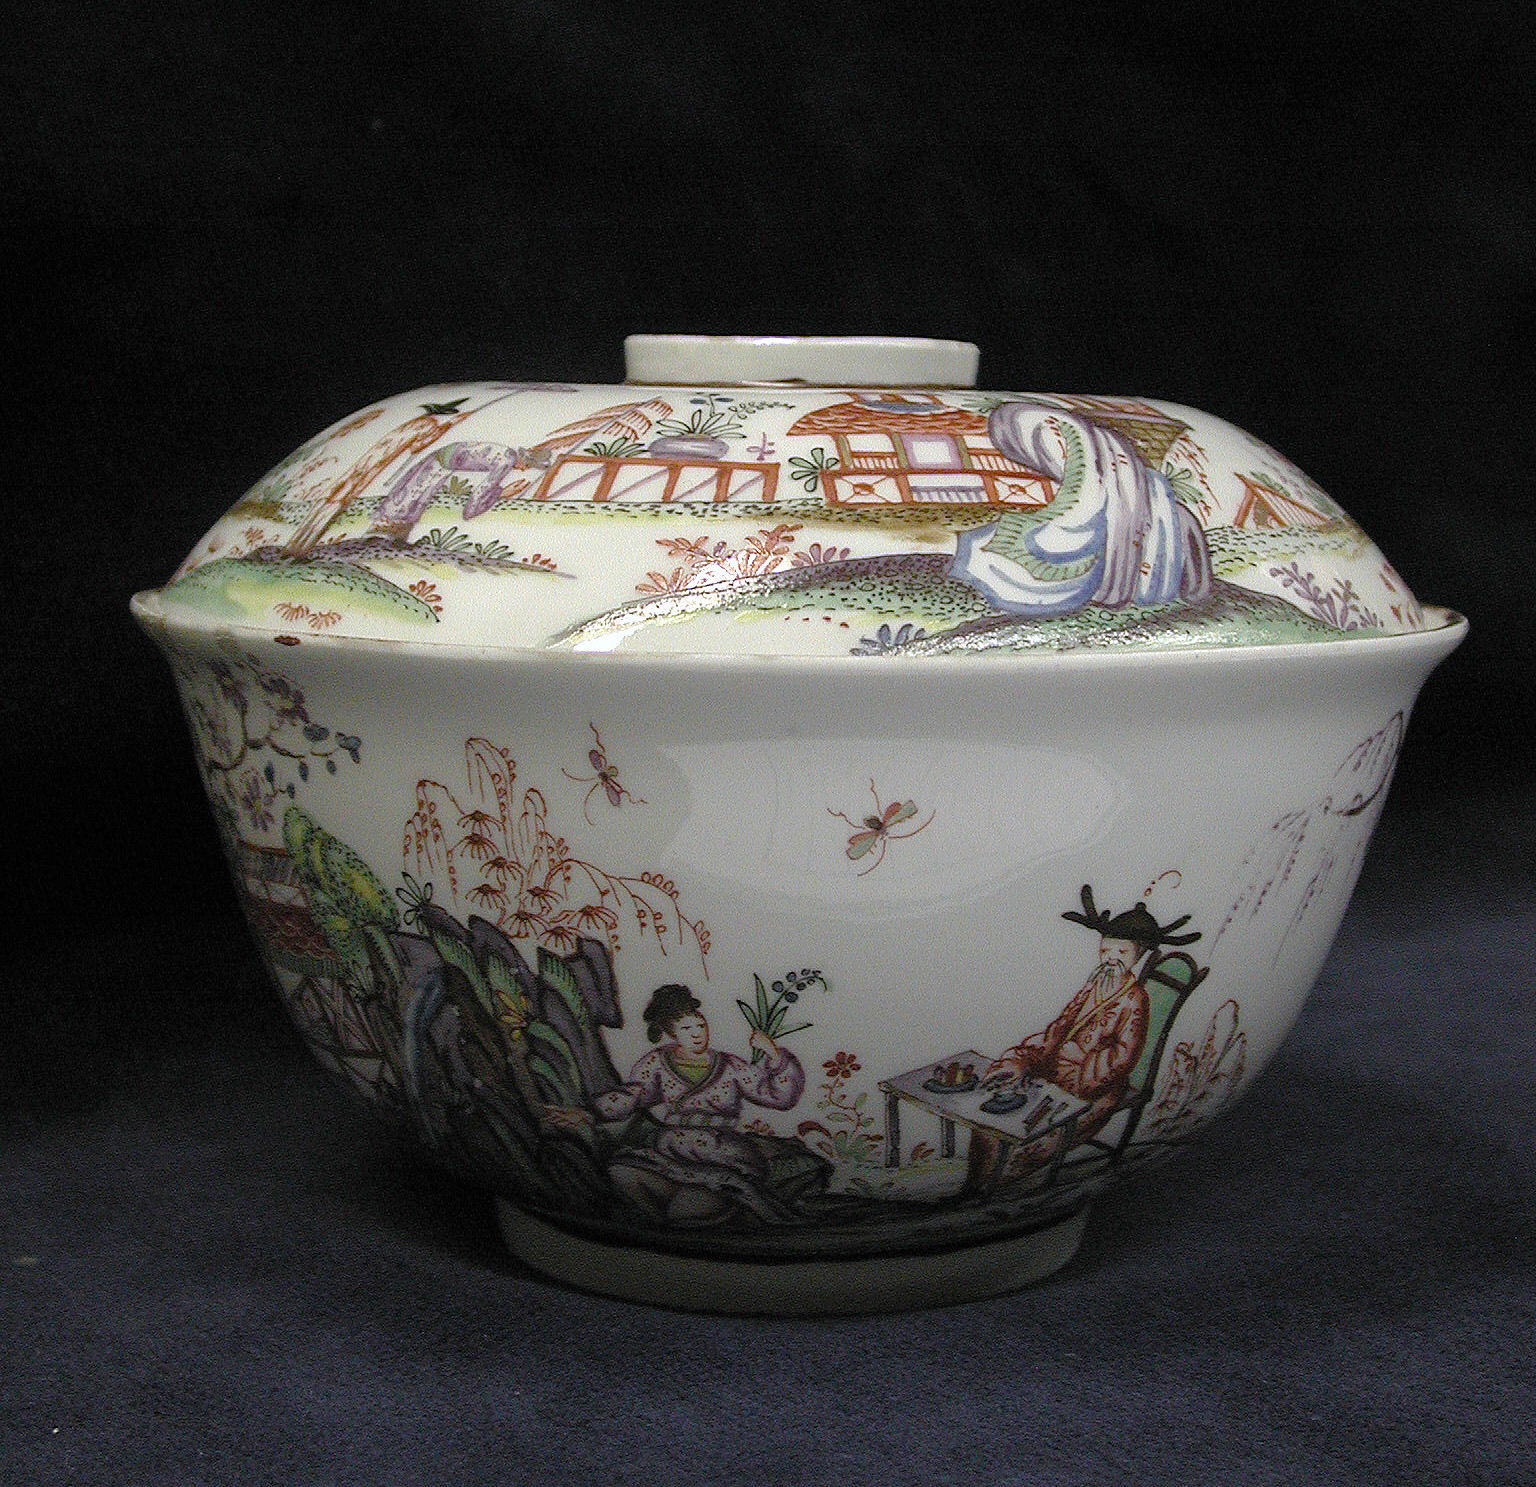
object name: bowl with cover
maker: vienna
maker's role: manufactory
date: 1720-1725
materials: hard paste porcelain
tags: chinoiserie,men,women,insects